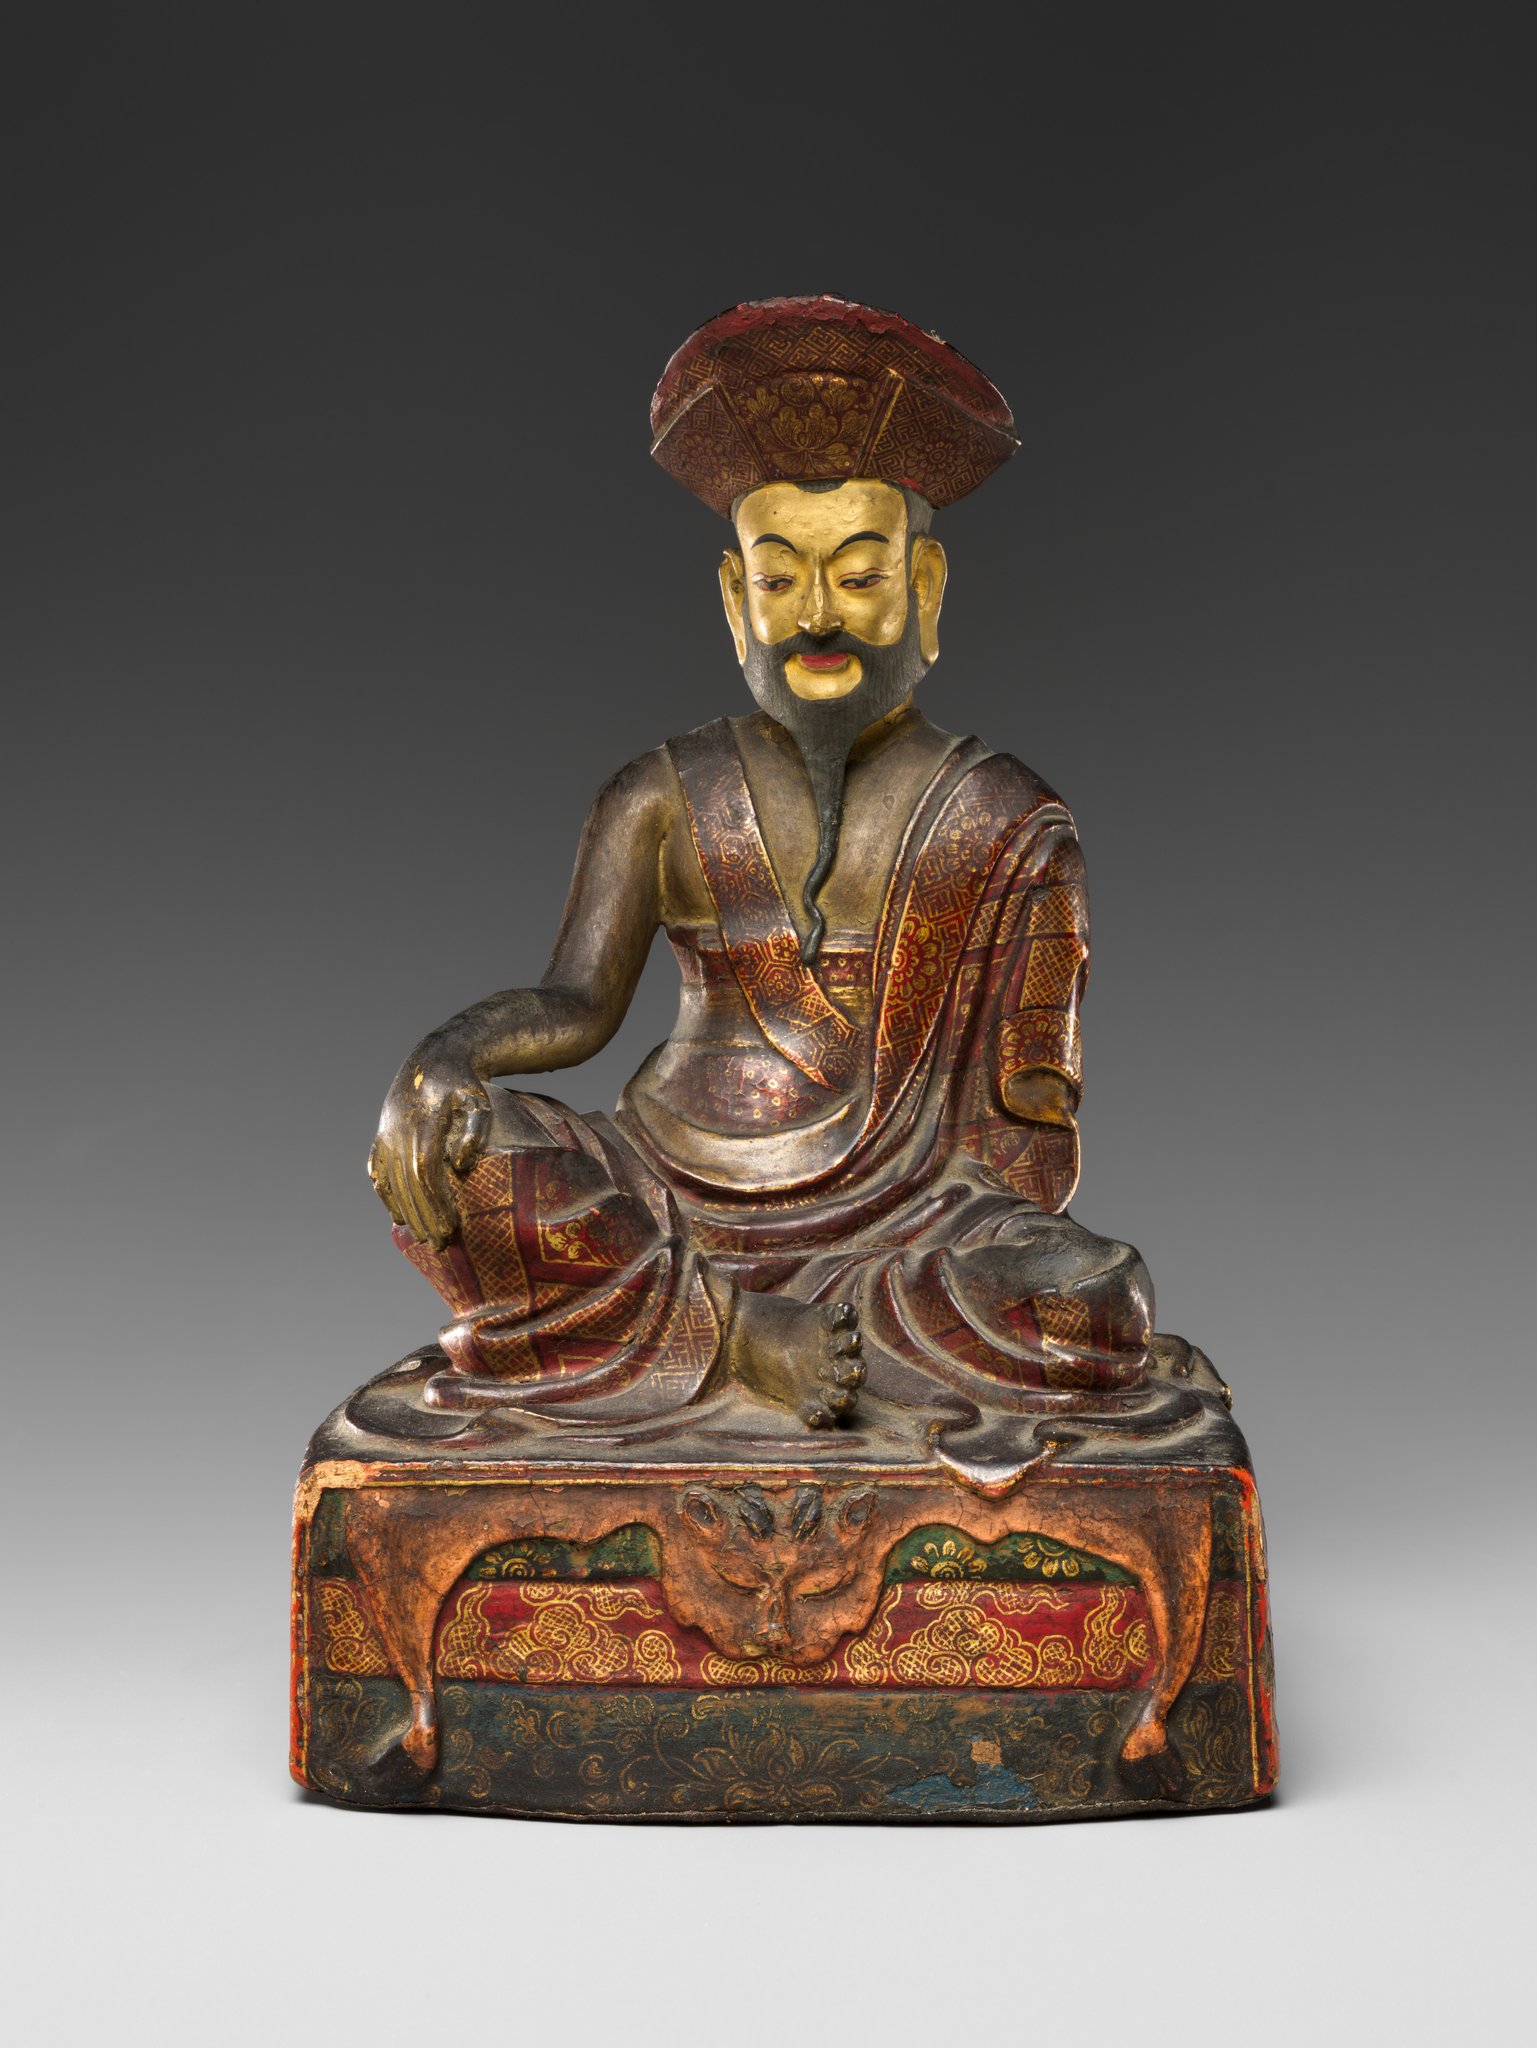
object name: figure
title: Portrait of Zhabdrung Ngawang Namgyal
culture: bhutan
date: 1701-1800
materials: clay, gold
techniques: gilding, polychrome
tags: men,portraits